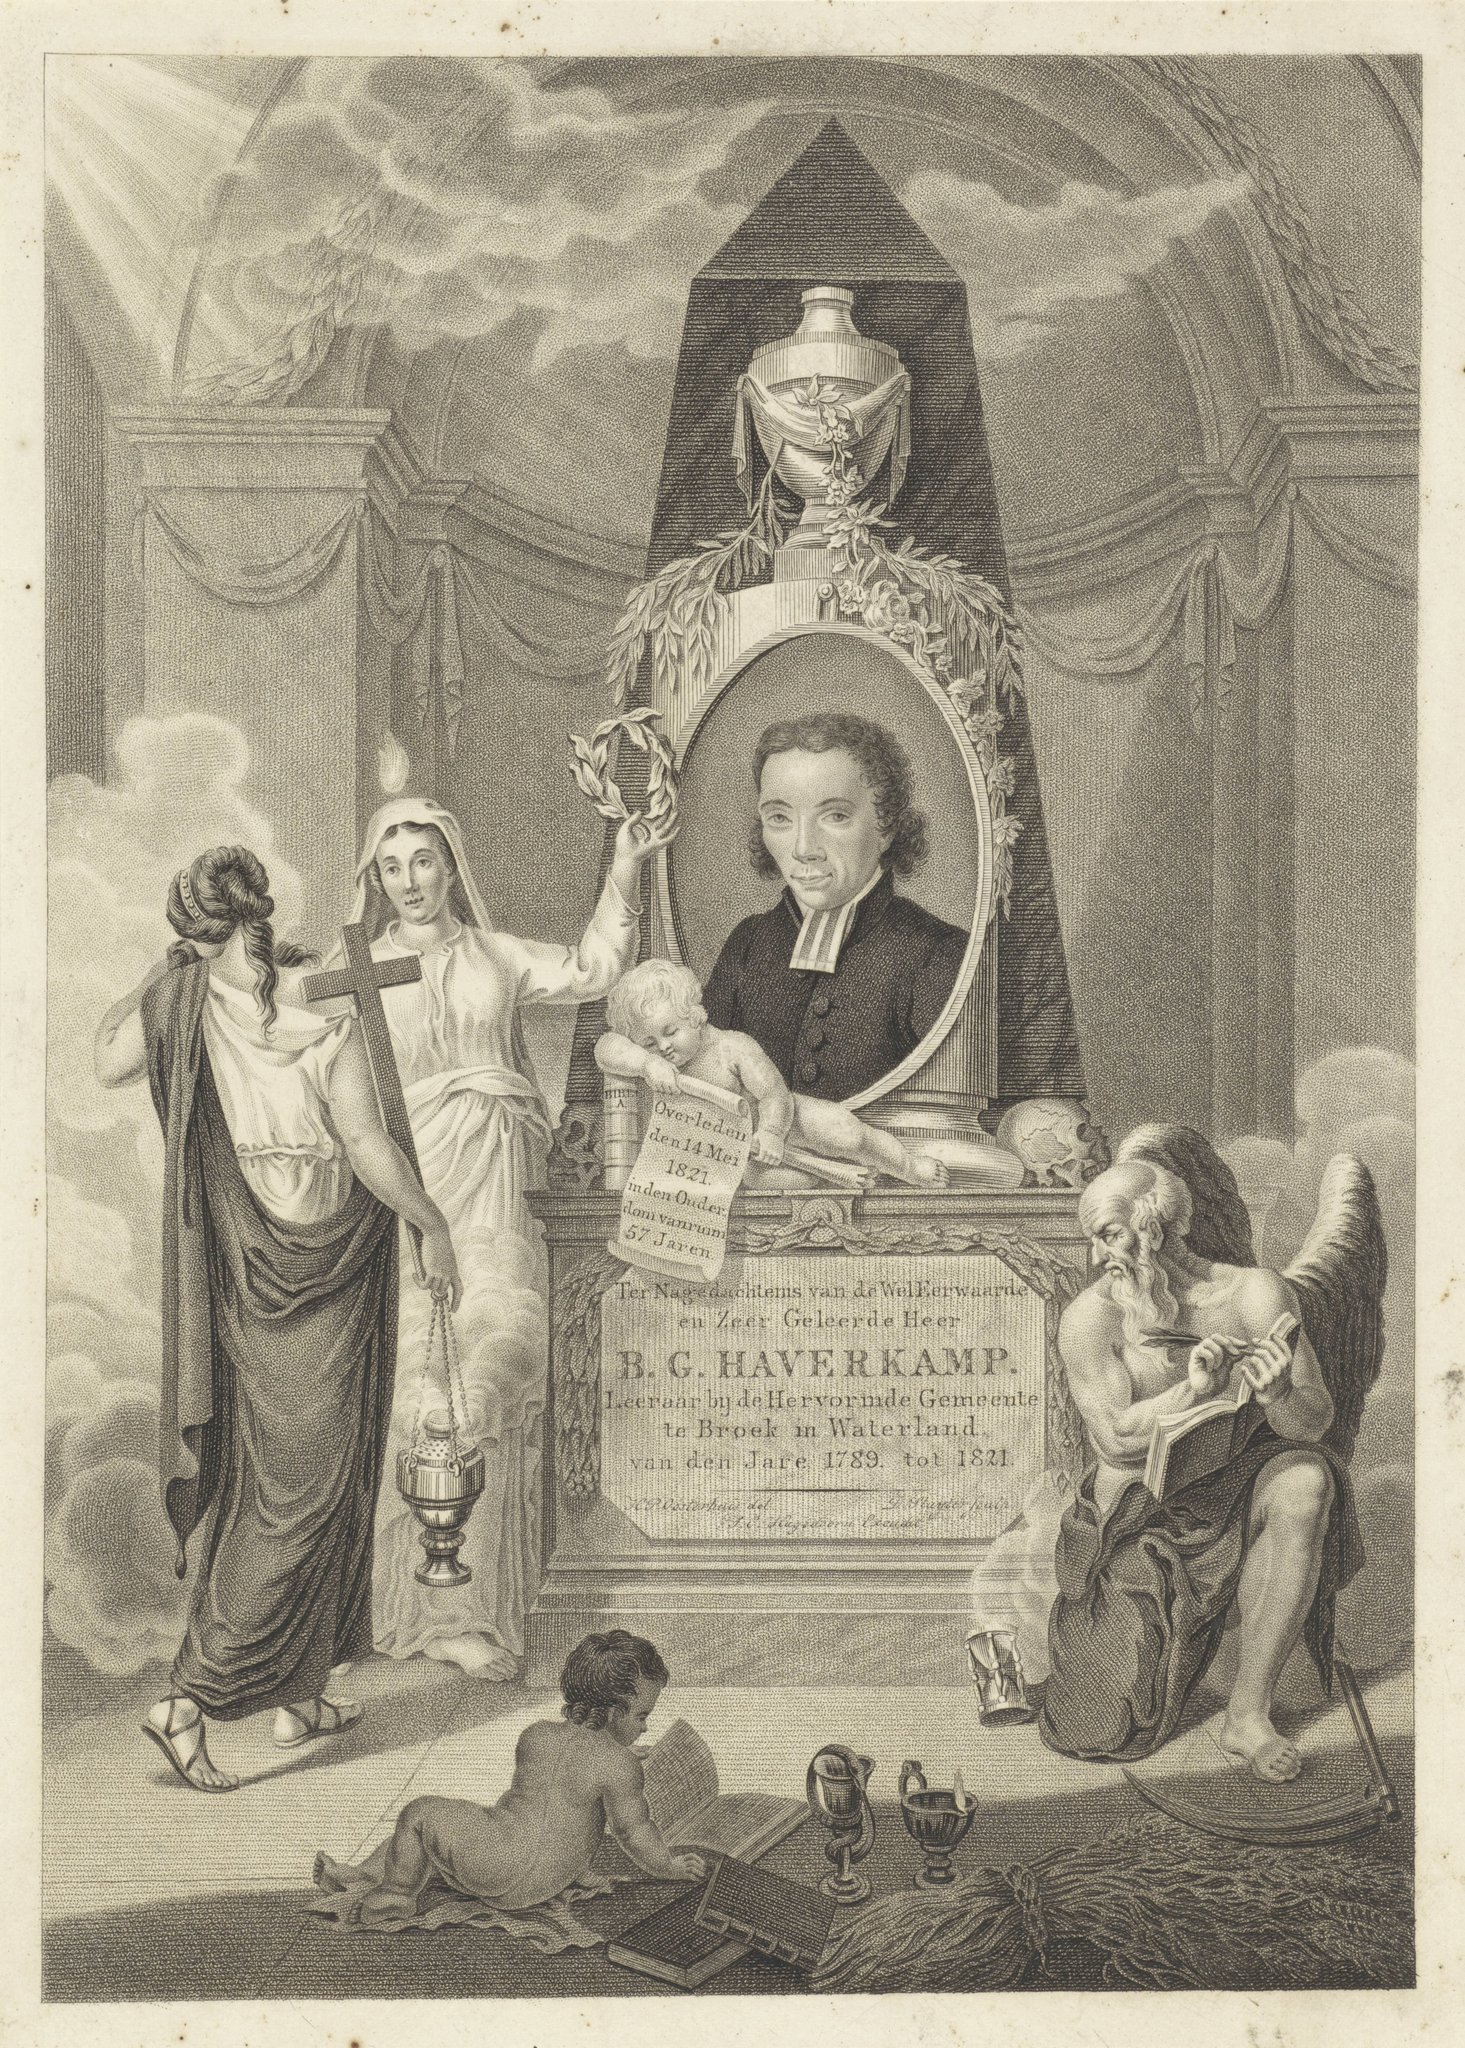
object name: print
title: Monument voor B.G. Haverkamp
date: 1821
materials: paper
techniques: engraving, etching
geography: amsterdam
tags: arnhem, fugacity of time, grave-building, monumental tomb, father time, man with wings and scythe, allegories and personifications ~ protestantism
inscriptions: collector's mark: Lugt 2228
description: Grafmonument met daarop het portret van de predikant B.G. Haverkamp. Het portret wordt geflankeerd door een schedel en een bijbel, waarop een slapende putto steunt. Deze houdt een een gedoofde fakkel vast en een papier met daarop de overlijdensdatum. Eronder een opschrift met zijn functie, en de jaren waarin hij in zijn gemeente werkzaam was. Naast het monument staan Geloof, met kruis en wierookvat, en Godsdienst. Vadertje Tijd zit geknield naast het monument, schrijvend in een boek. Op de voorgrond zit een putto met boeken, een door een slang omslingerde beker, een brandende lamp en een korenschoof. Met bijbehorend tekstblad met uitleg.